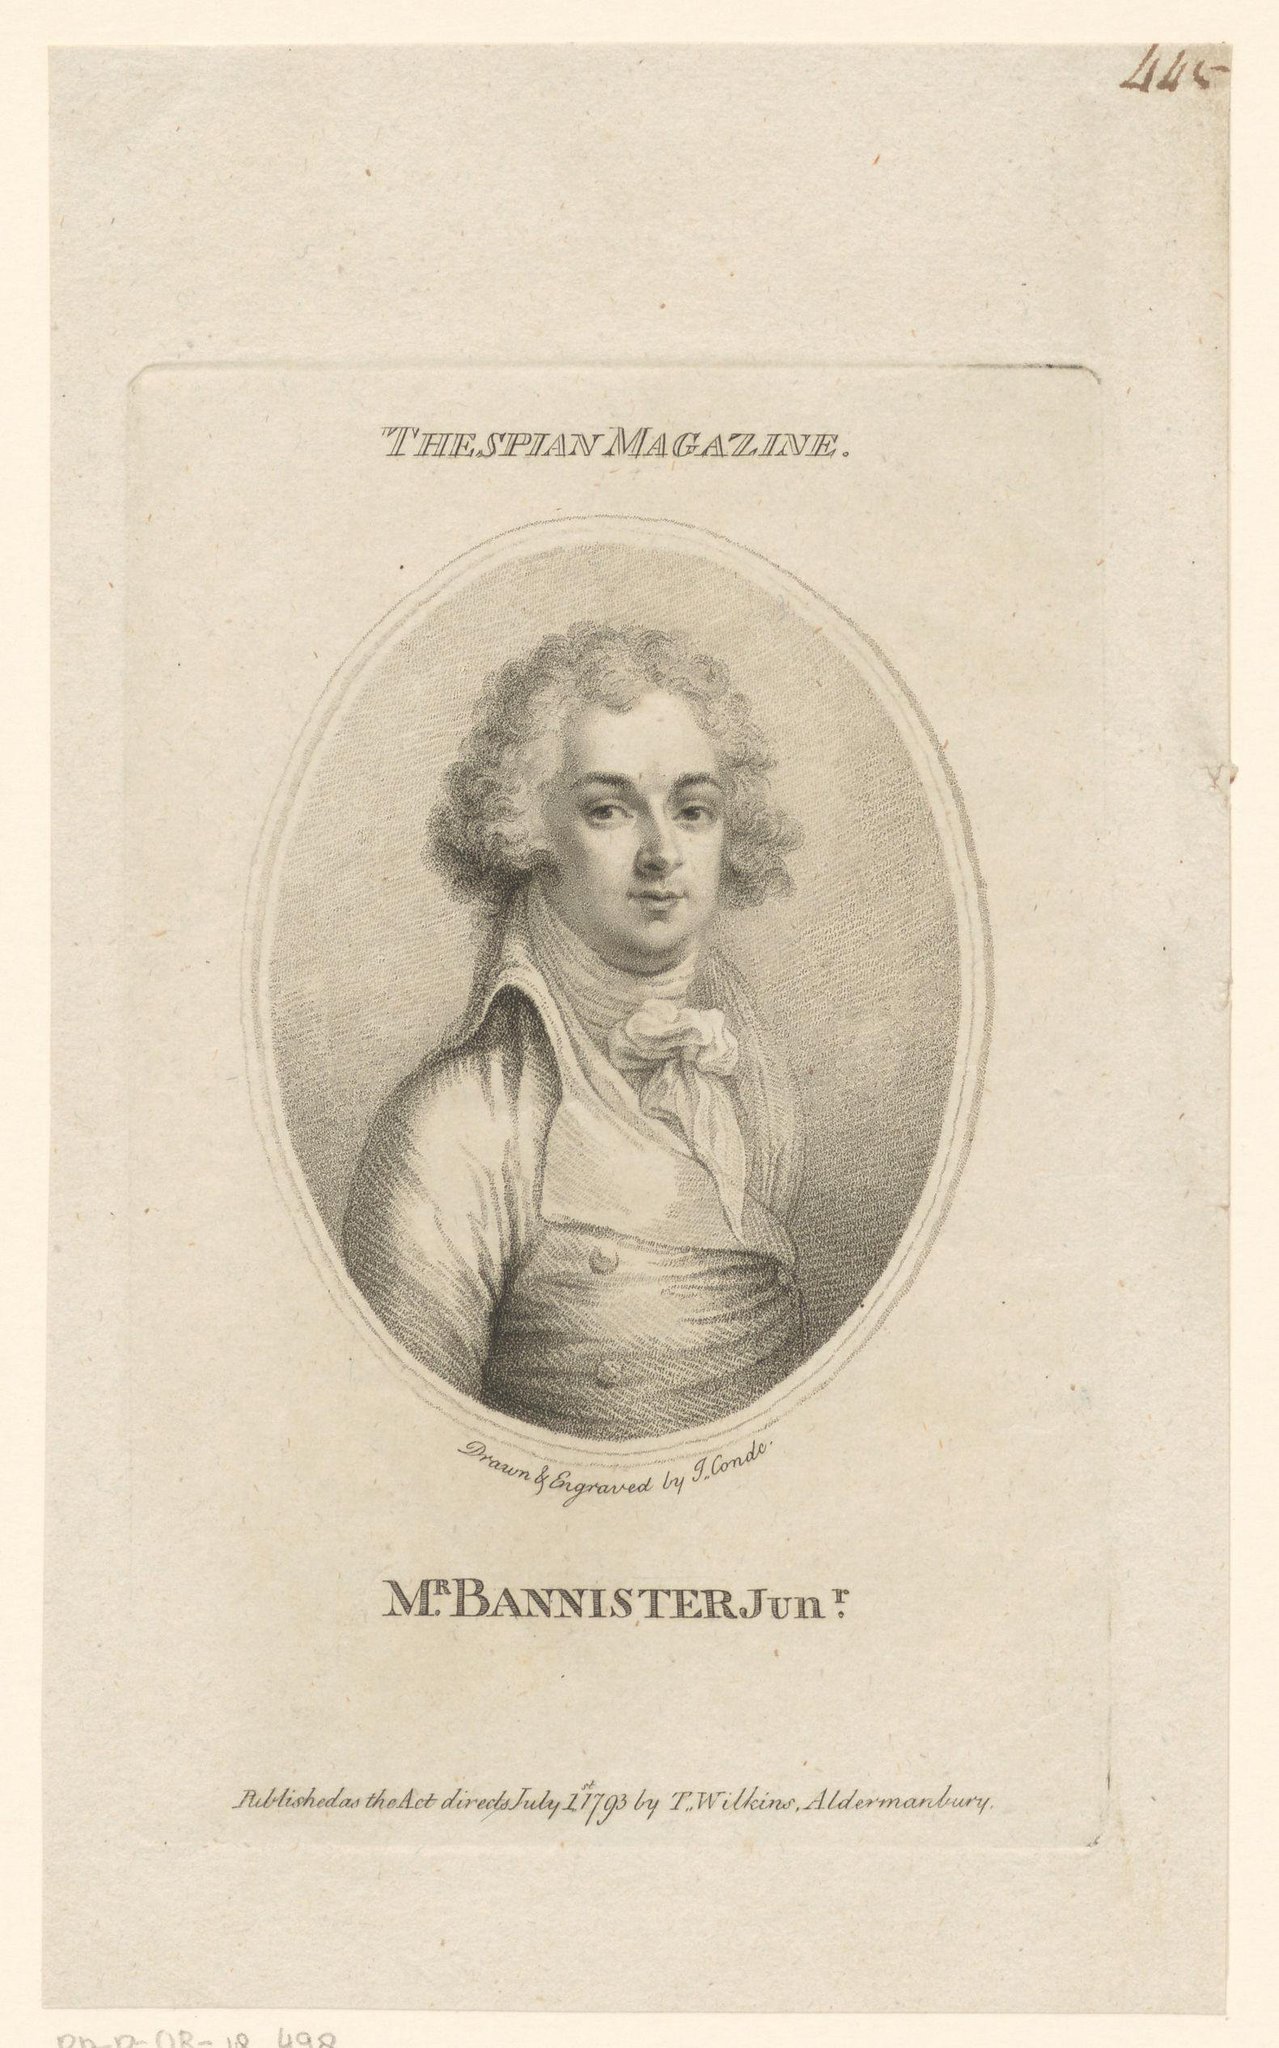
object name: print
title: Portret van John Bannister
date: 1793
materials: paper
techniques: stippling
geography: aldermanbury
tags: deptford, historical persons, portrait of actor, actress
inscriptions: number: ‘445’, collector's mark: Lugt 2228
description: Prent gebruikt in: Thespian Magazine (1793).